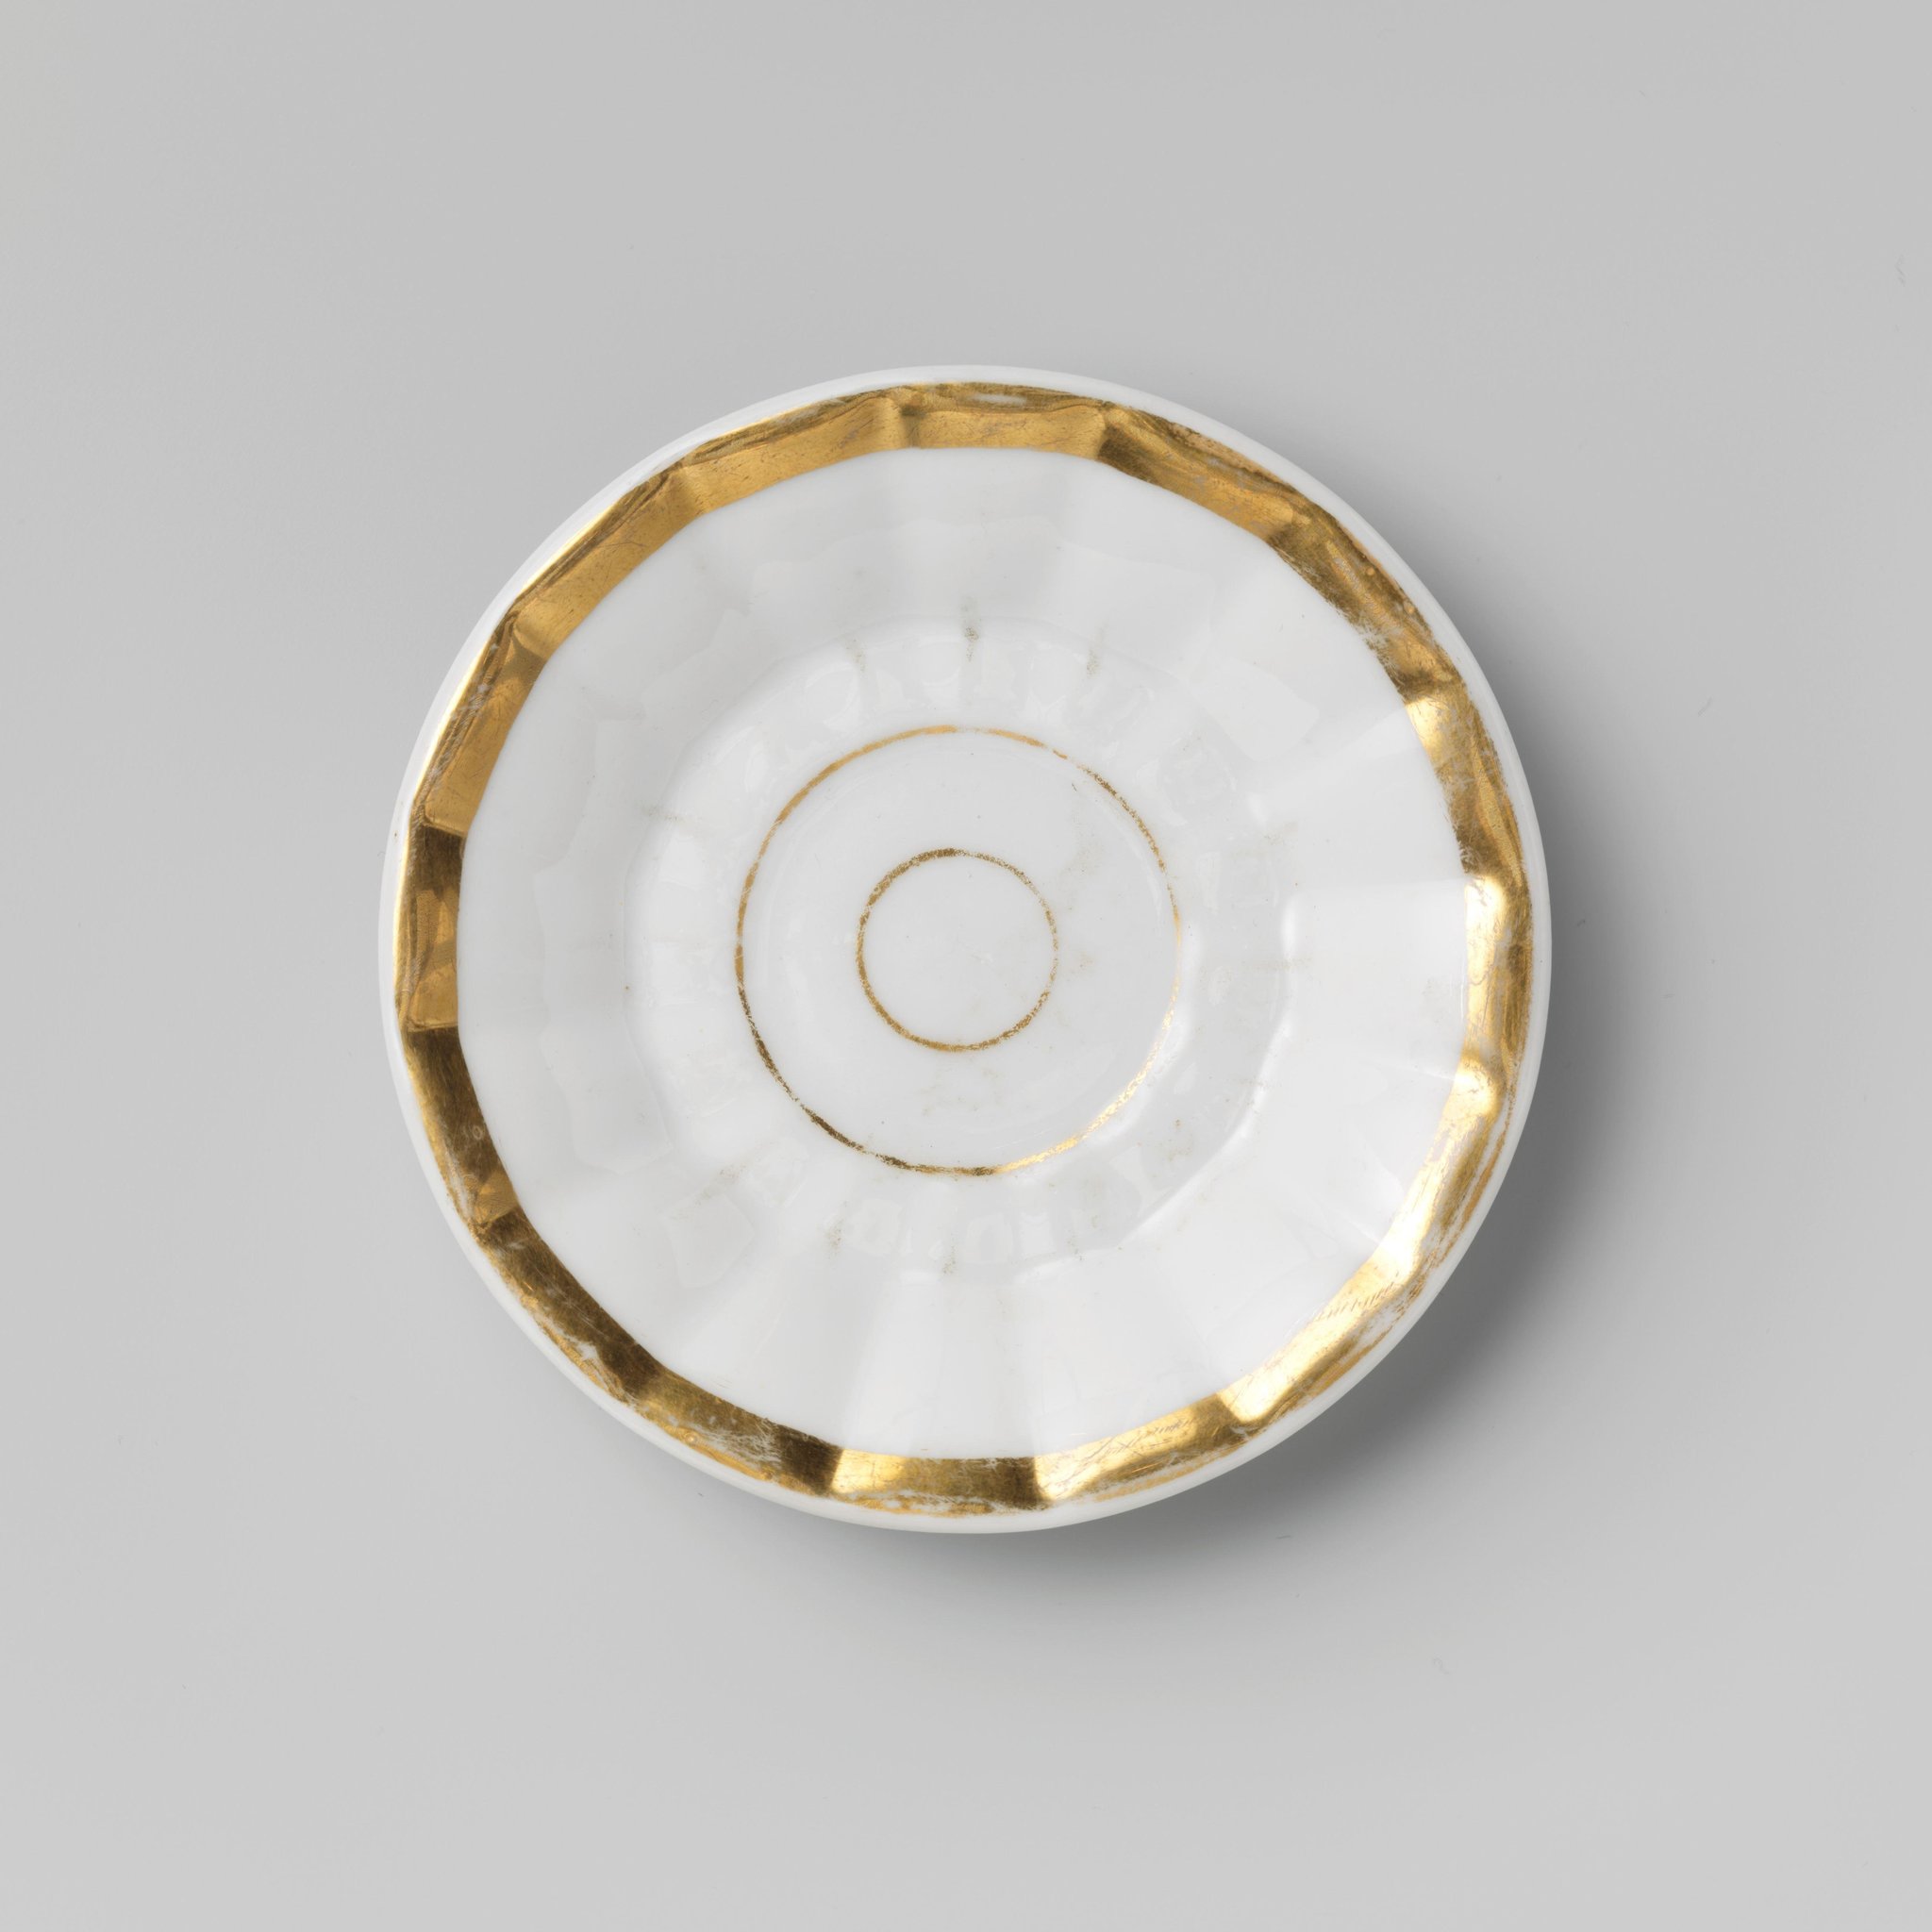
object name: object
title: Schotel (zonder afbeelding)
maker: Anonymous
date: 1850-1949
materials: ceramic